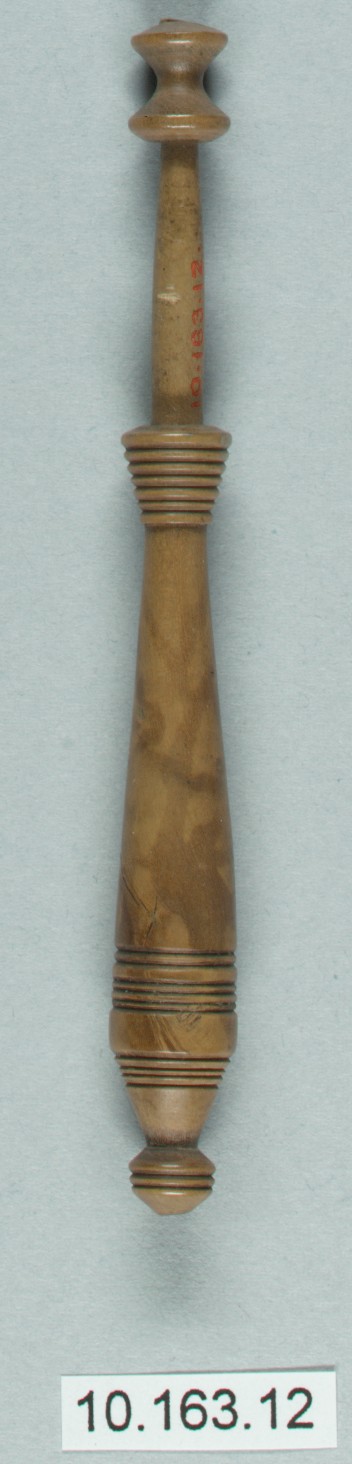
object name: bobbin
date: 1801-1900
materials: wood